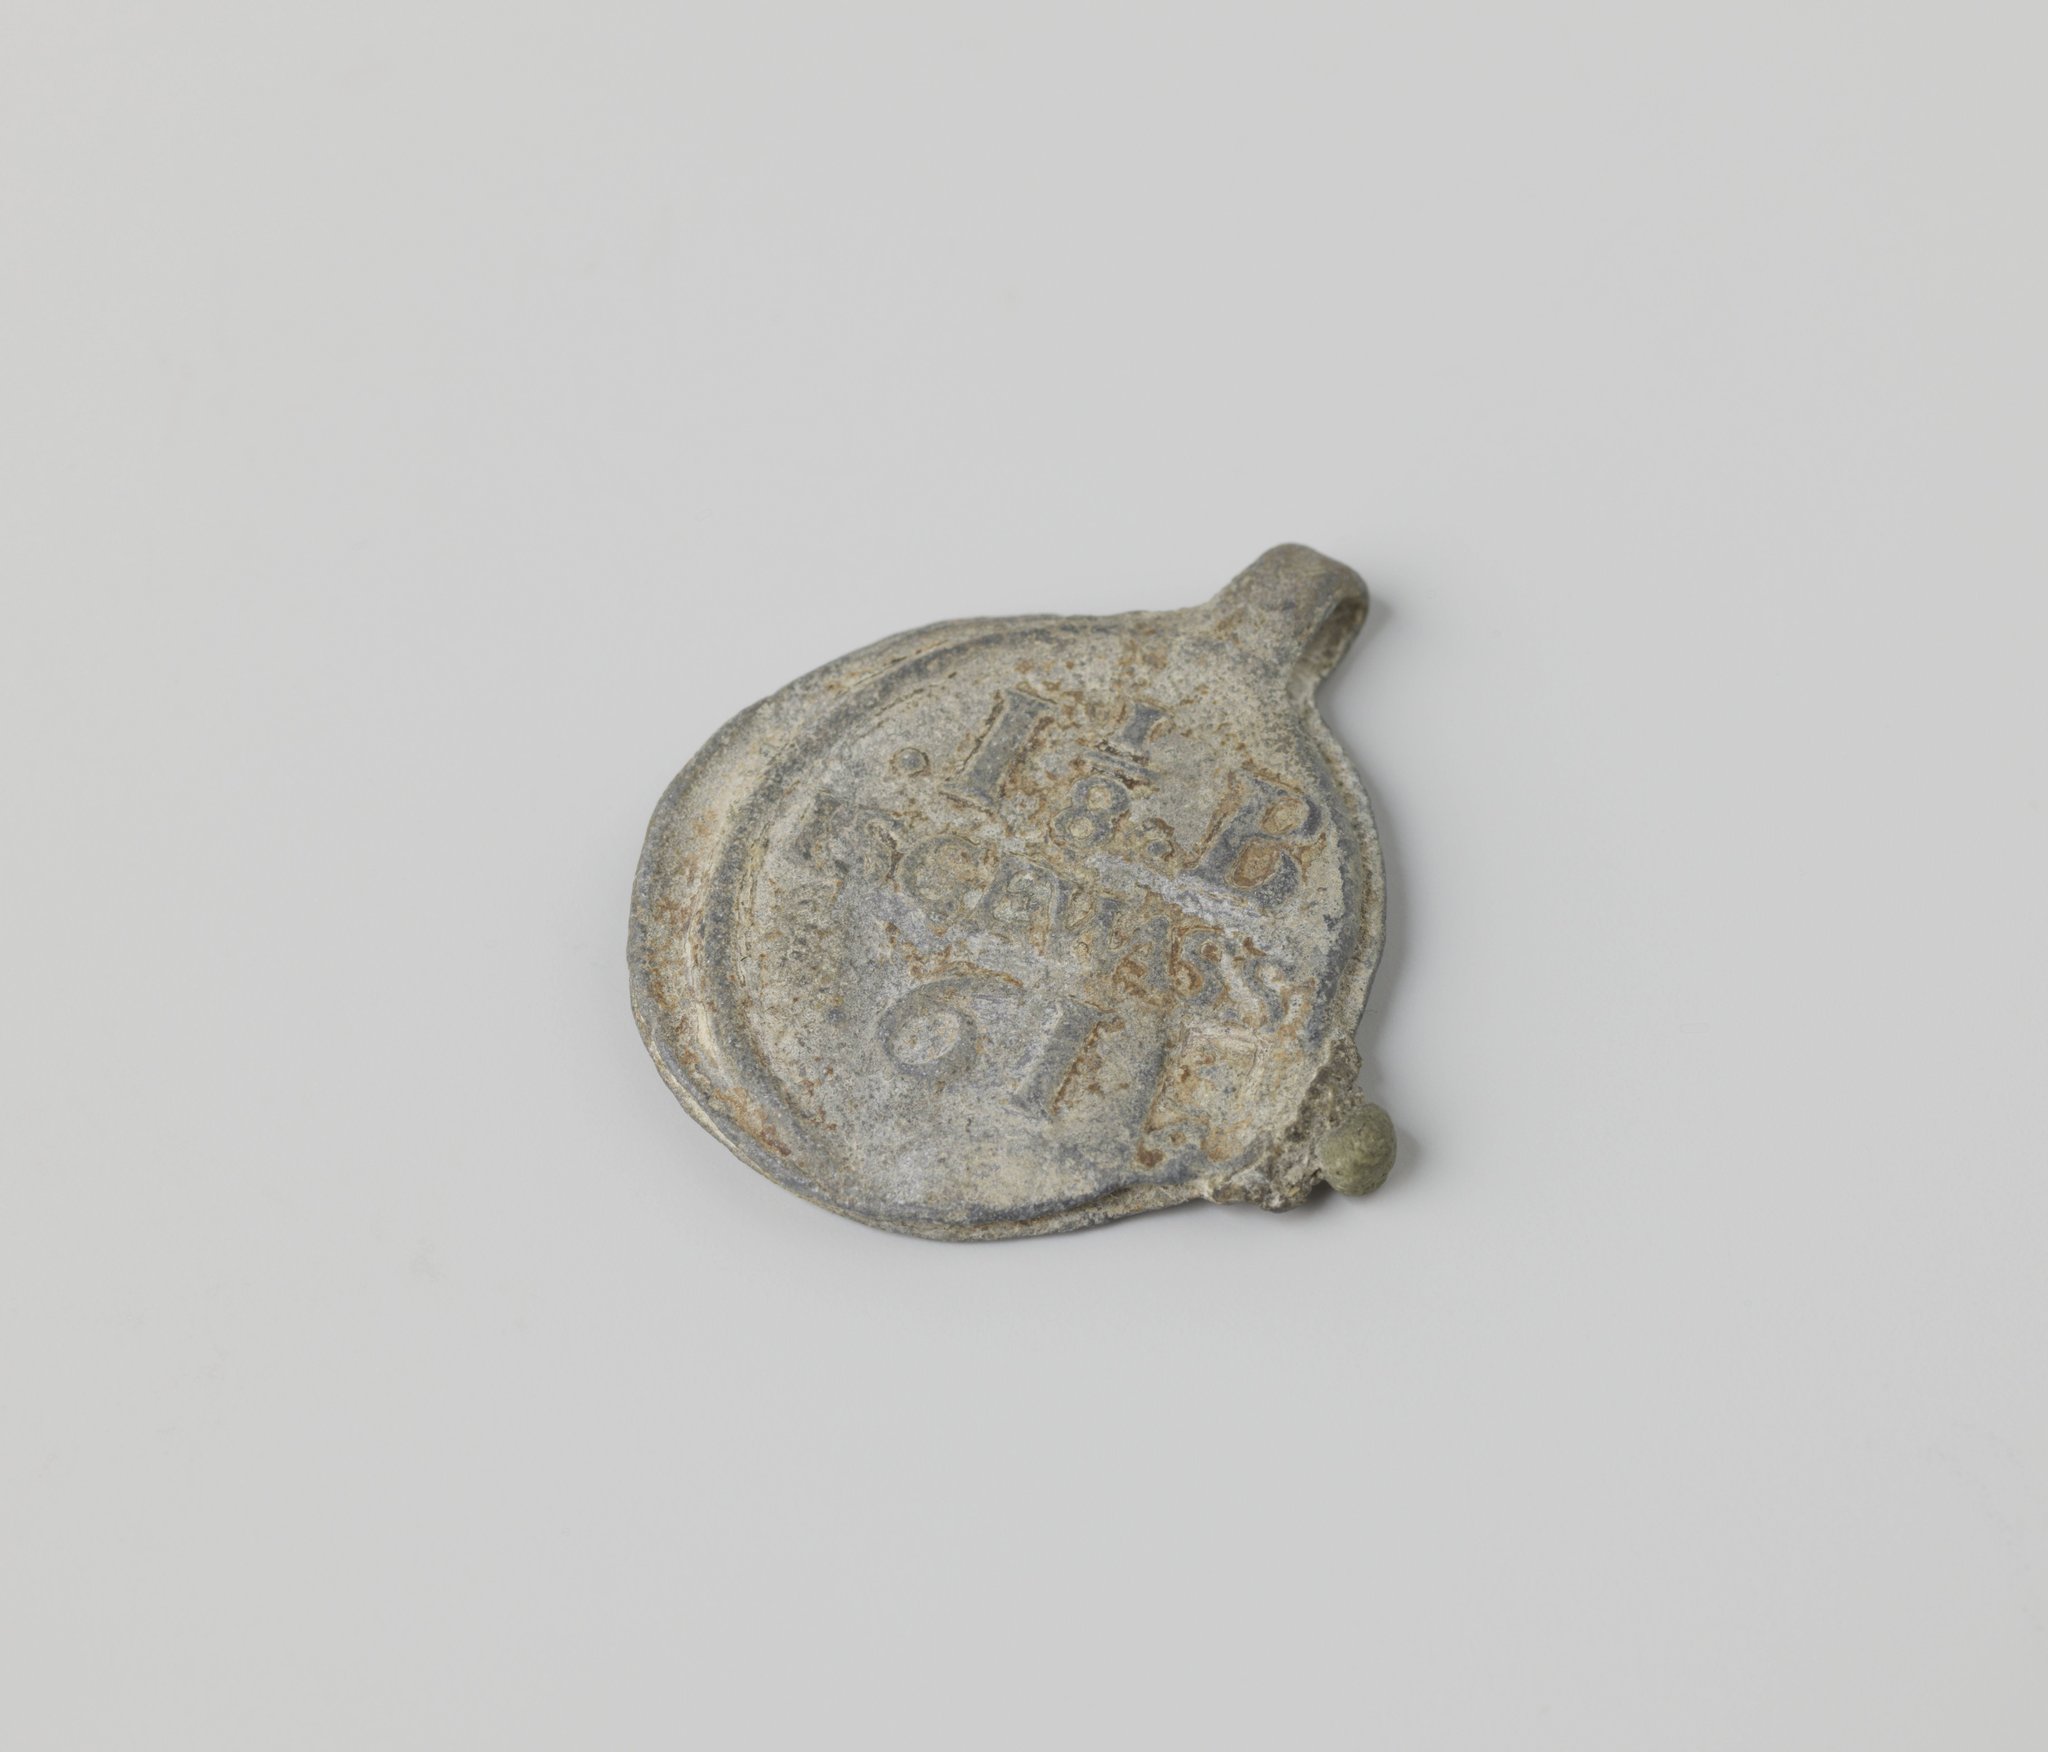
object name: lakenloodje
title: Lakenloodje uit Leiden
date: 1600-1750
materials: lead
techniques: striking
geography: leiden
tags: leiden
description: Loden lakenloodje uit Leiden, de twee zijden samengeknepen waardoor een oogje werd gevormd, aan de rechterzijde ergens aan bevestigd geweest. Op de voorzijde enkele cijfers: "1 1/8 B" duidt op de breedte van de stof in ellen; "gewass" kan duiden op een wasbehandeling. Op de achterzijde wapen van Leiden en tekst: 'leiden in hollandt'.